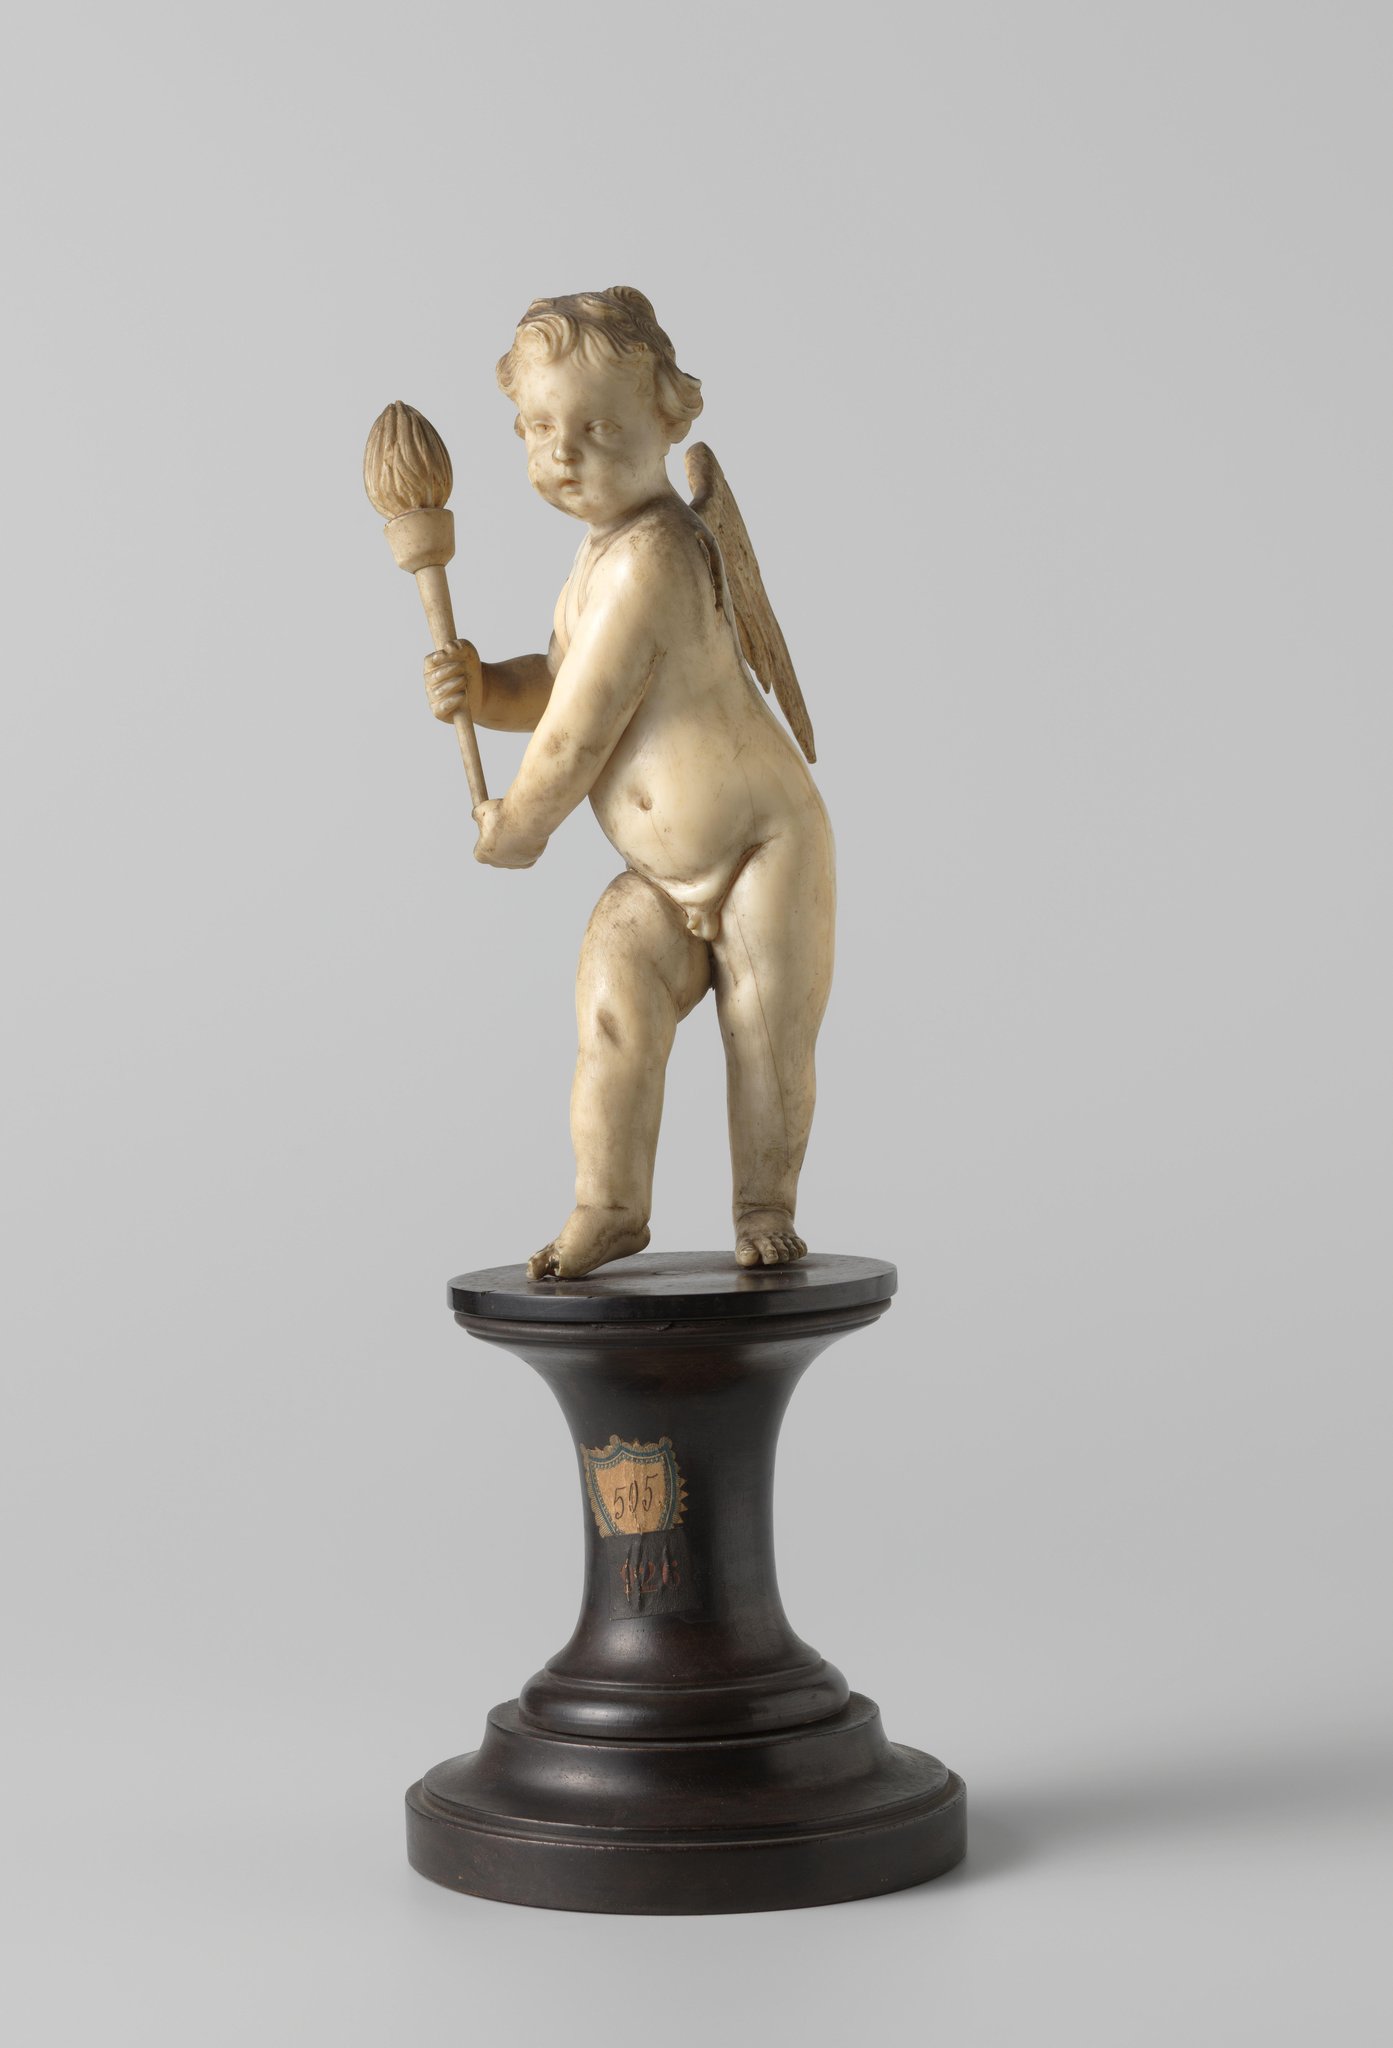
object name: sculpture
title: Amor in de vorm van een engel met fakkel.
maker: Anonymous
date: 1700-1800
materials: ivory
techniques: cutting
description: Amorfiguur van ivoor in de vorm van een engel met fakkel.